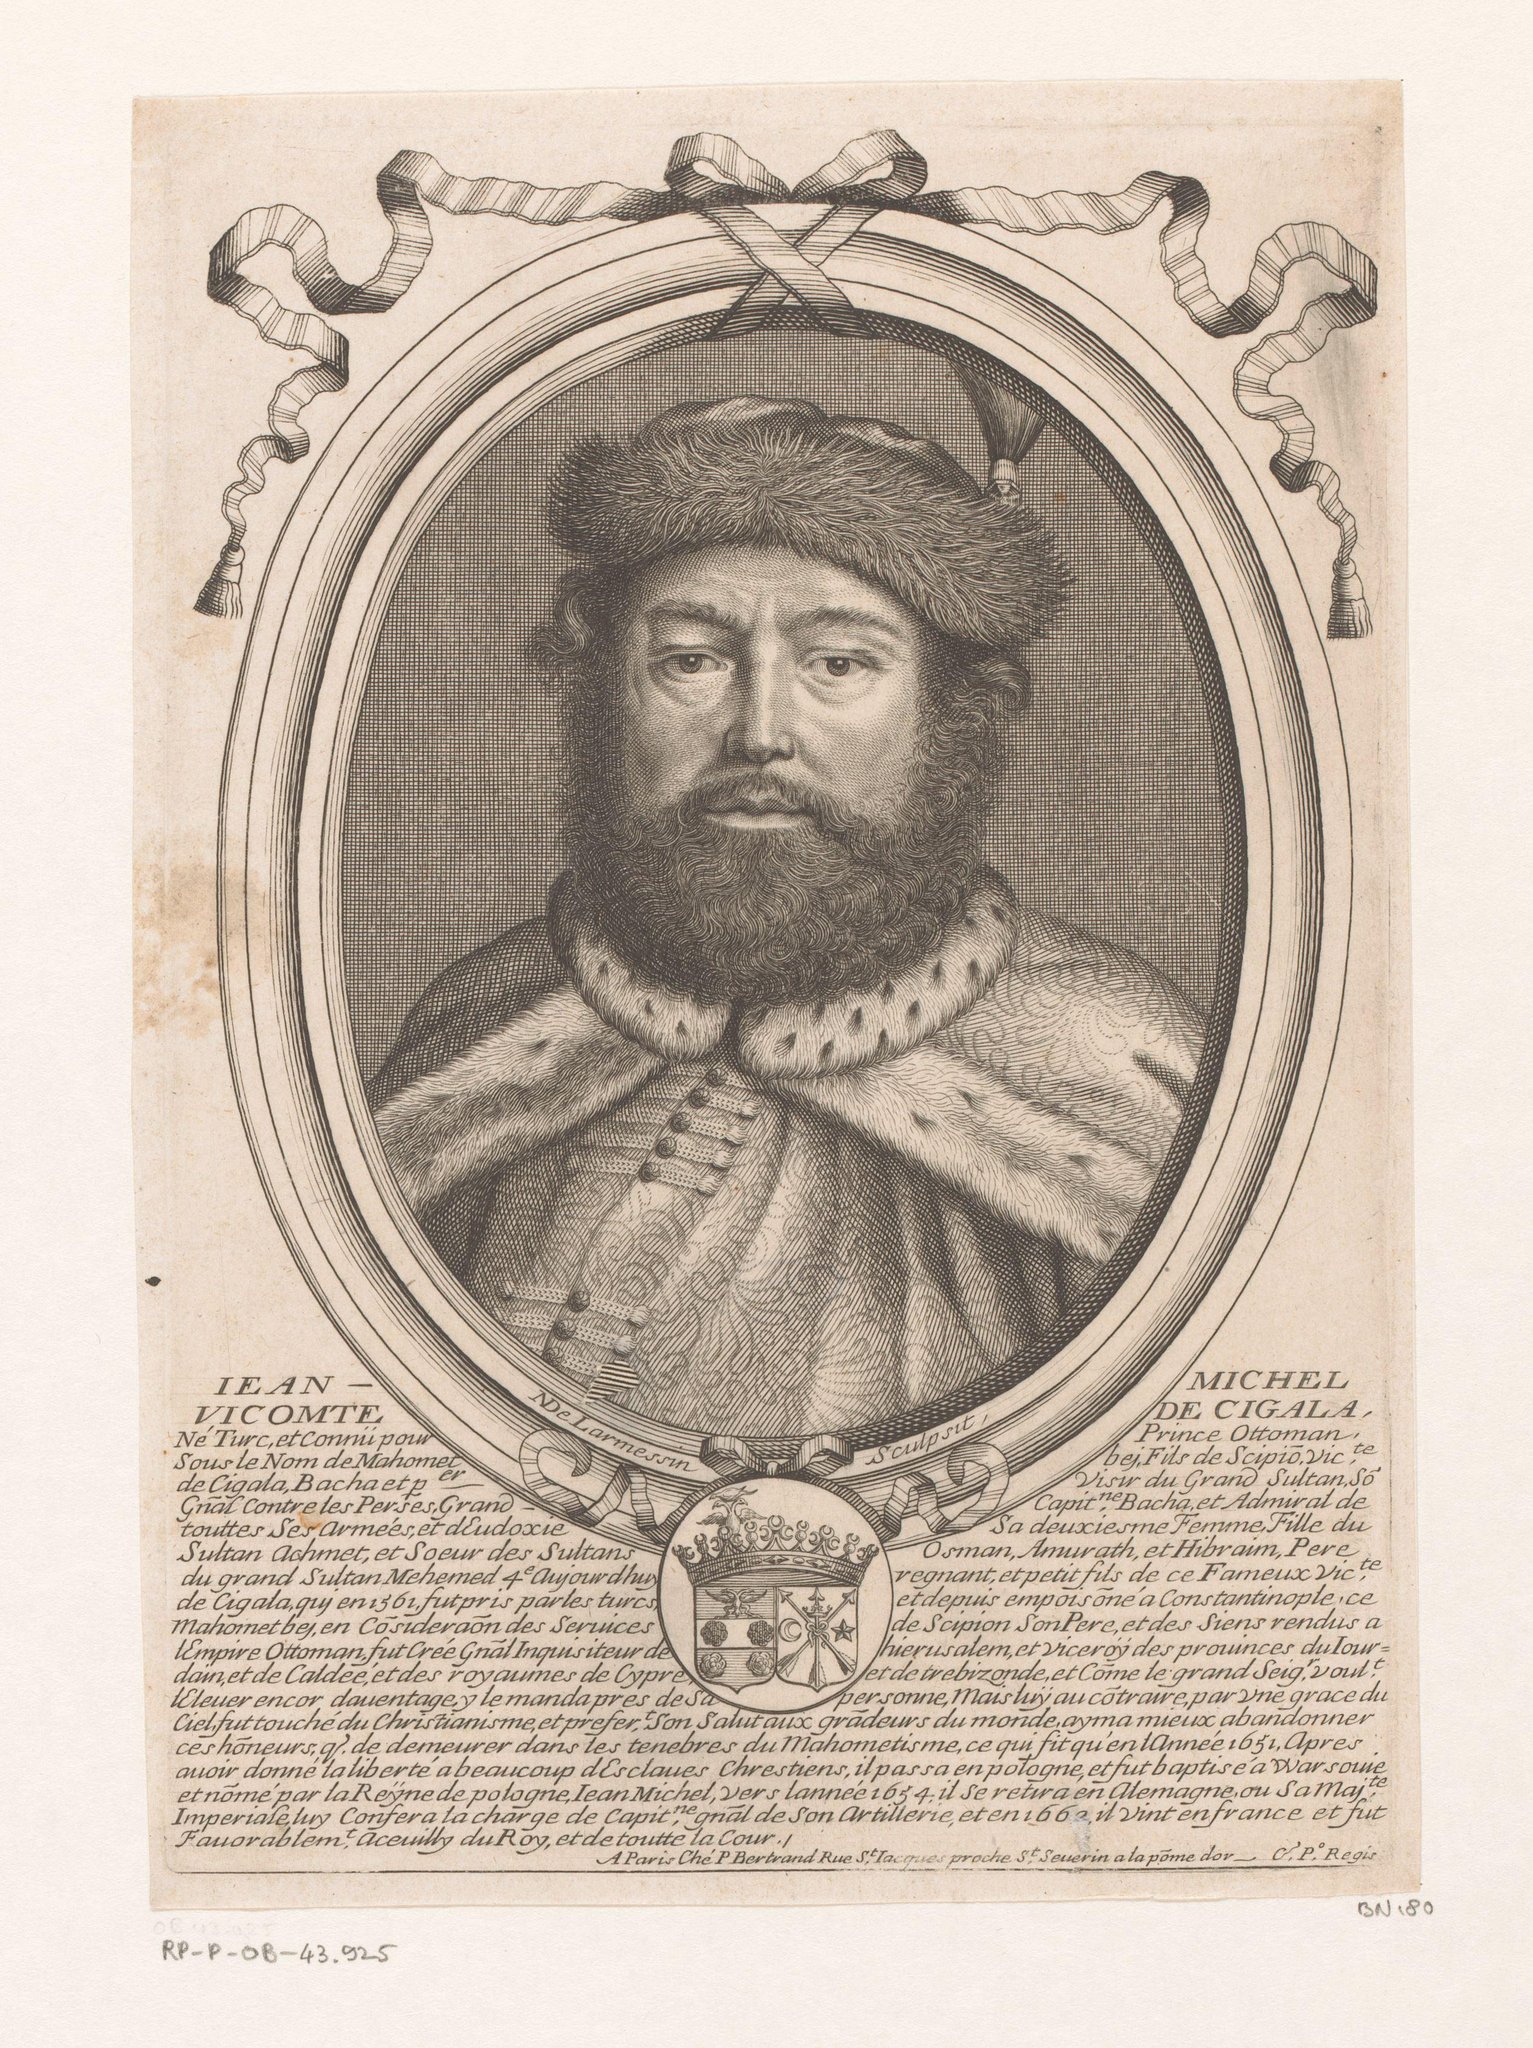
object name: print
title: Portretten van prominente figuren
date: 1642-1678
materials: paper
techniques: engraving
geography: france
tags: historical persons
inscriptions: collector's mark: Lugt 2228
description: Maakt deel uit van een grootschalige serie met portretten van prominente figuren. Binnen de serie bevindt zich een sectie getiteld 'Les Augustes Représentations De tous les Roys De France depuis Pharamond Iusqu'à Louys XIIII'. De serie werd respectievelijk uitgegeven door Pierre Bertrand, door zijn weduwe en door De Larmessin zelf.